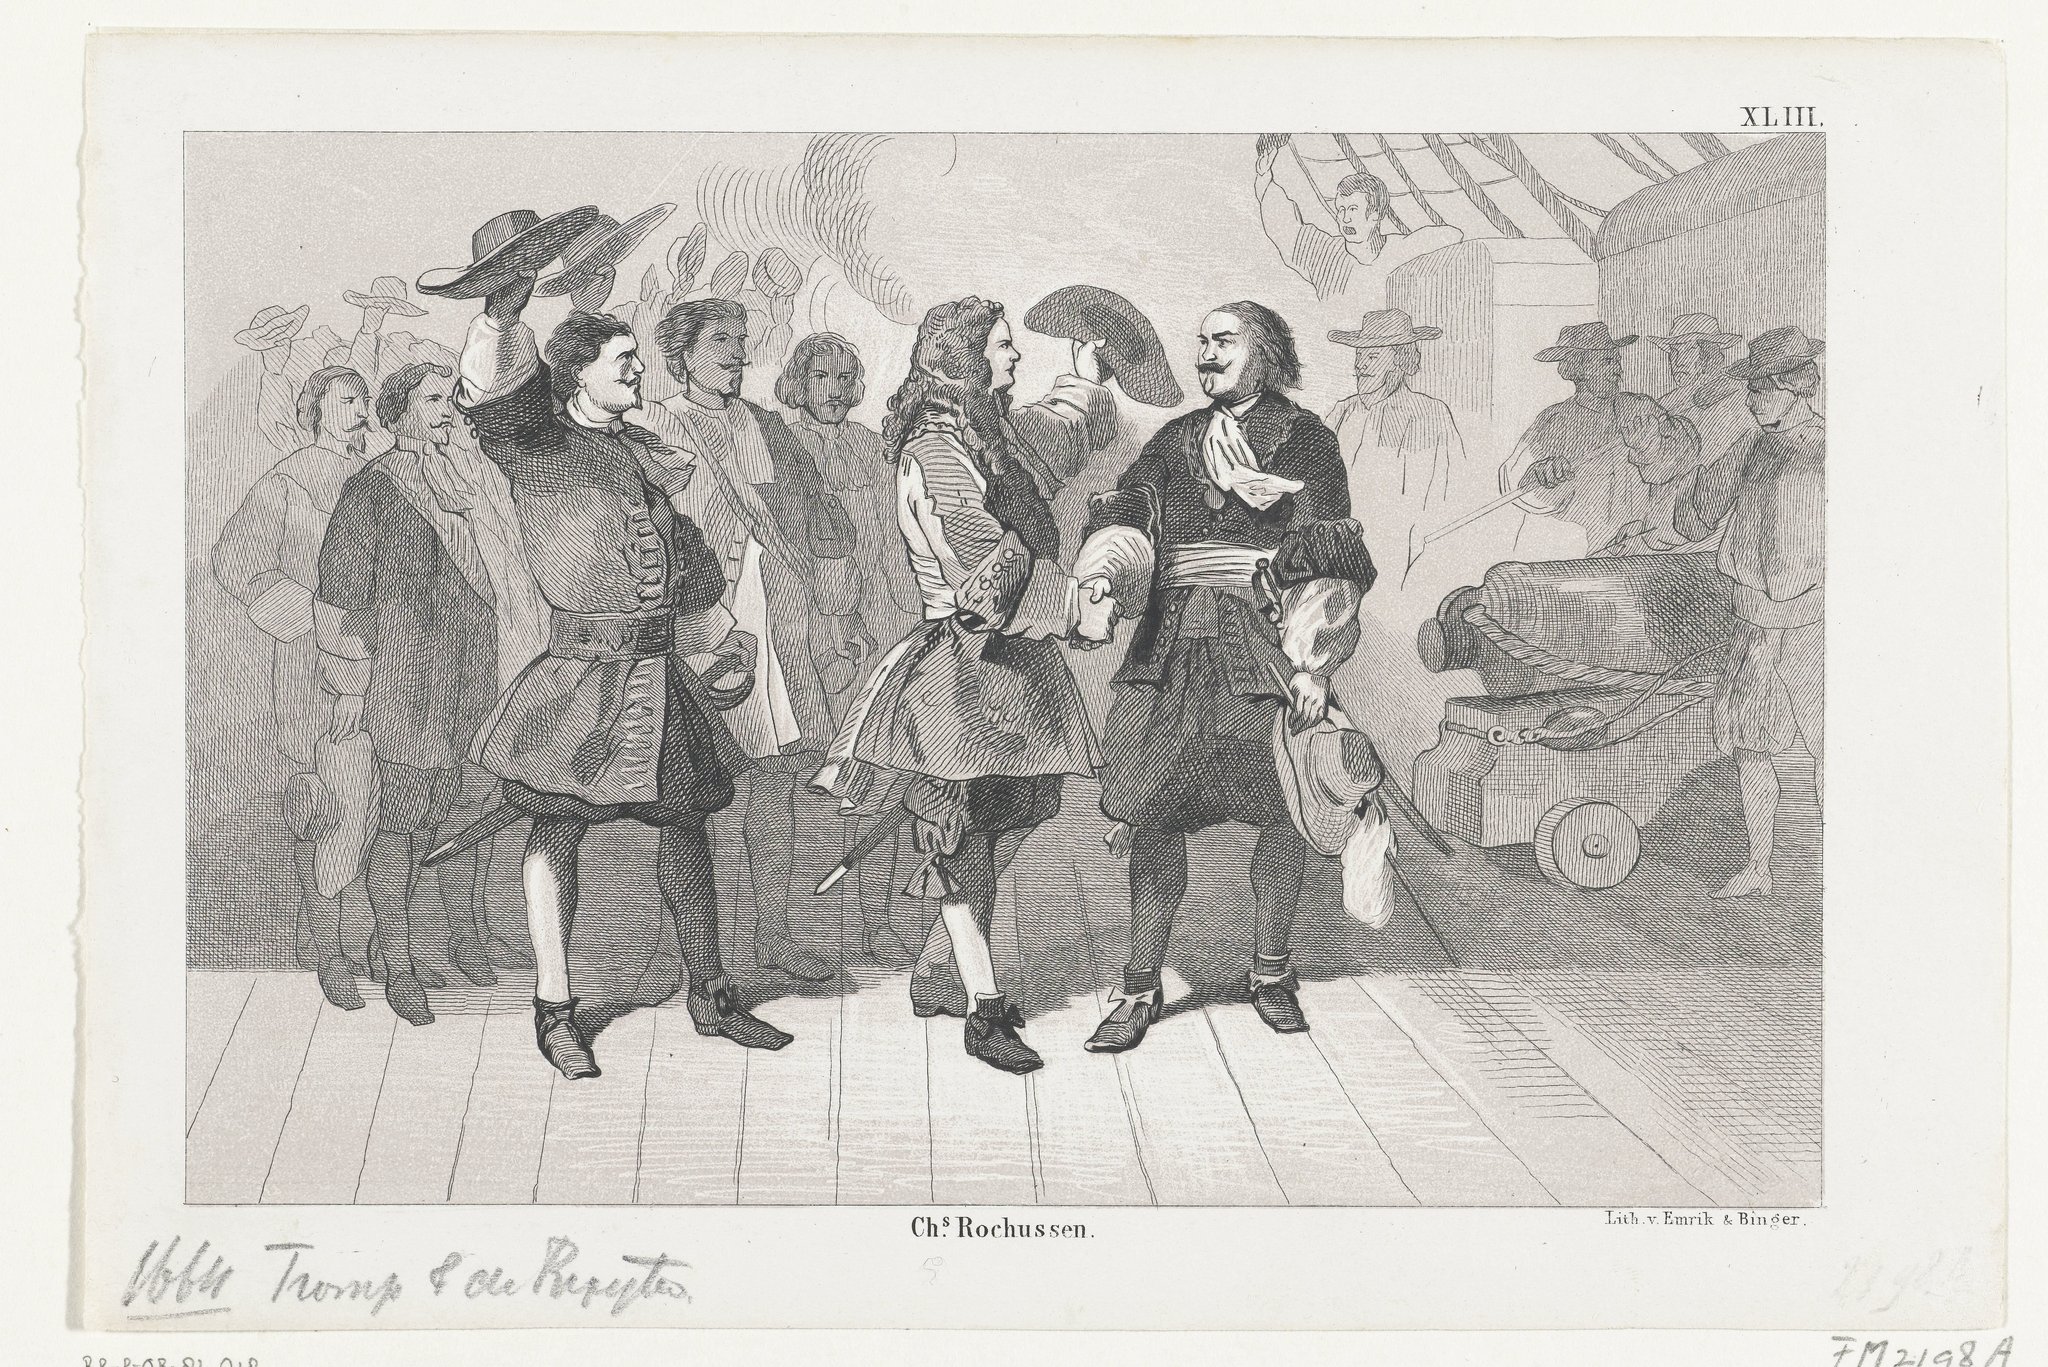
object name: print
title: Cornelis Tromp en Michiel Adriaenszoon de Ruyter, 1664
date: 1853-1861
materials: paper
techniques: tone lithography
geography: netherlands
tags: flushing, michiel adriaenszoon de ruyter, rotterdam, amsterdam, cornelis tromp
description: Gebruikt als illustratie in: Jacob van Lennep, De geschiedenis des vaderlands in schetsen en afbeeldingen, Binger, Amsterdam 1855-1861, 8 delen, pl. XLIII. Dit nummer is een door het RPK toegevoegd nummer en staat niet in Frederik Muller, het werk waar de prent voor is gemaakt of uit afkomstig is, staat wel vermeld in Frederik Muller.